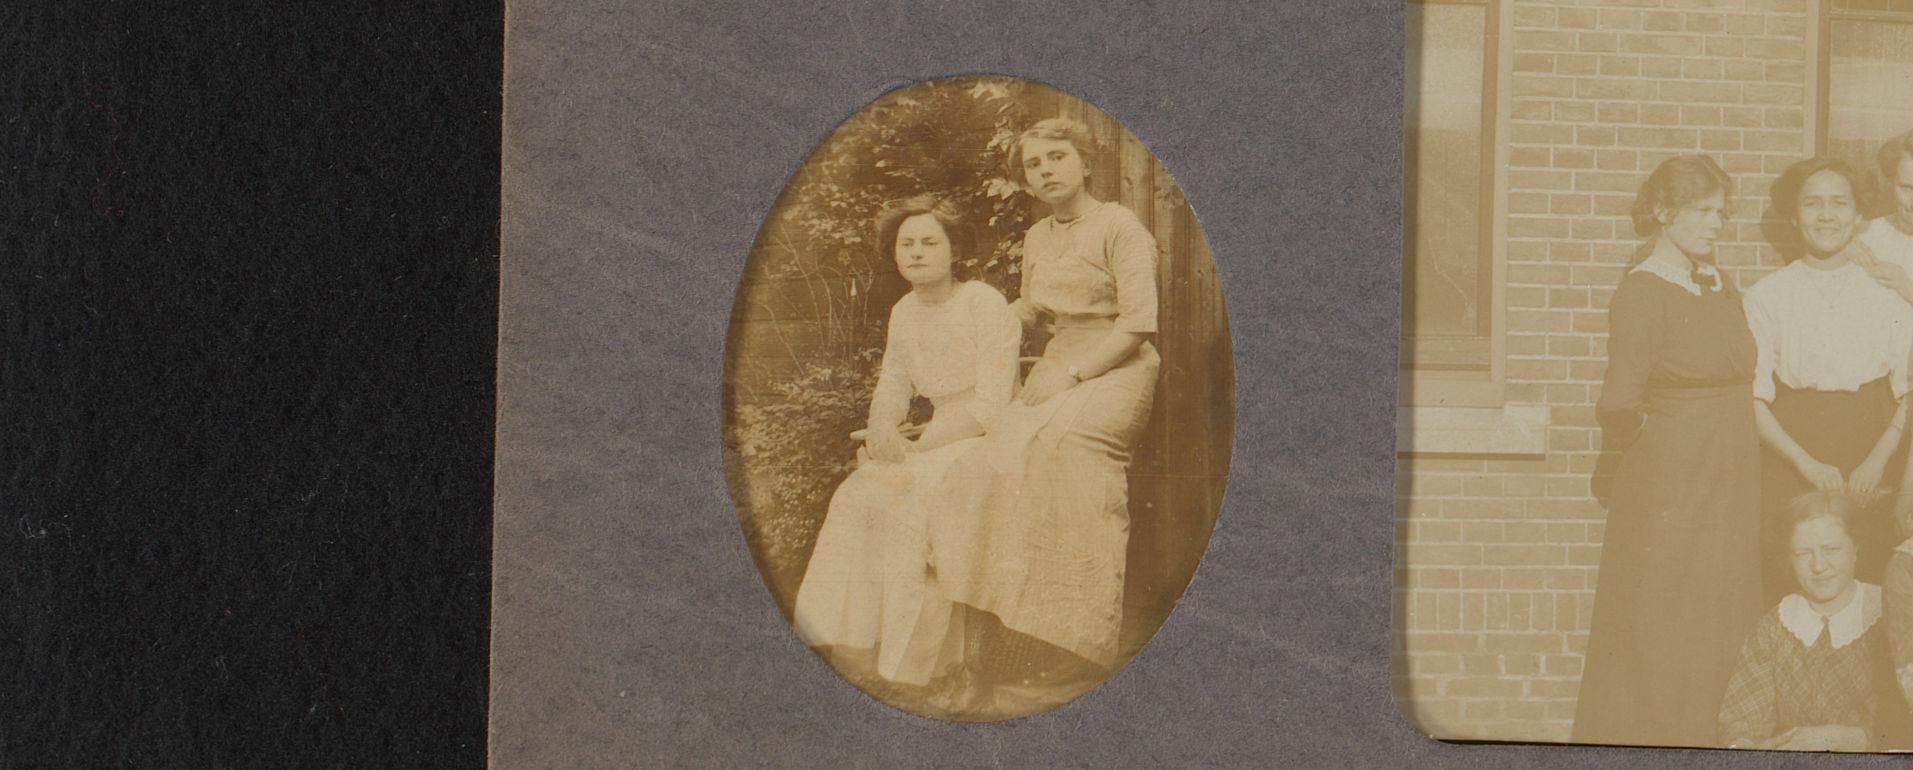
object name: album leaf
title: Twee jonge vrouwen in een tuin, links Wiesje Merkus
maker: Anonymous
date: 1908-1912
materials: paper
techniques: gelatin silver print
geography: netherlands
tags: wiesje merkus, adolescent, young woman, maiden, netherlands